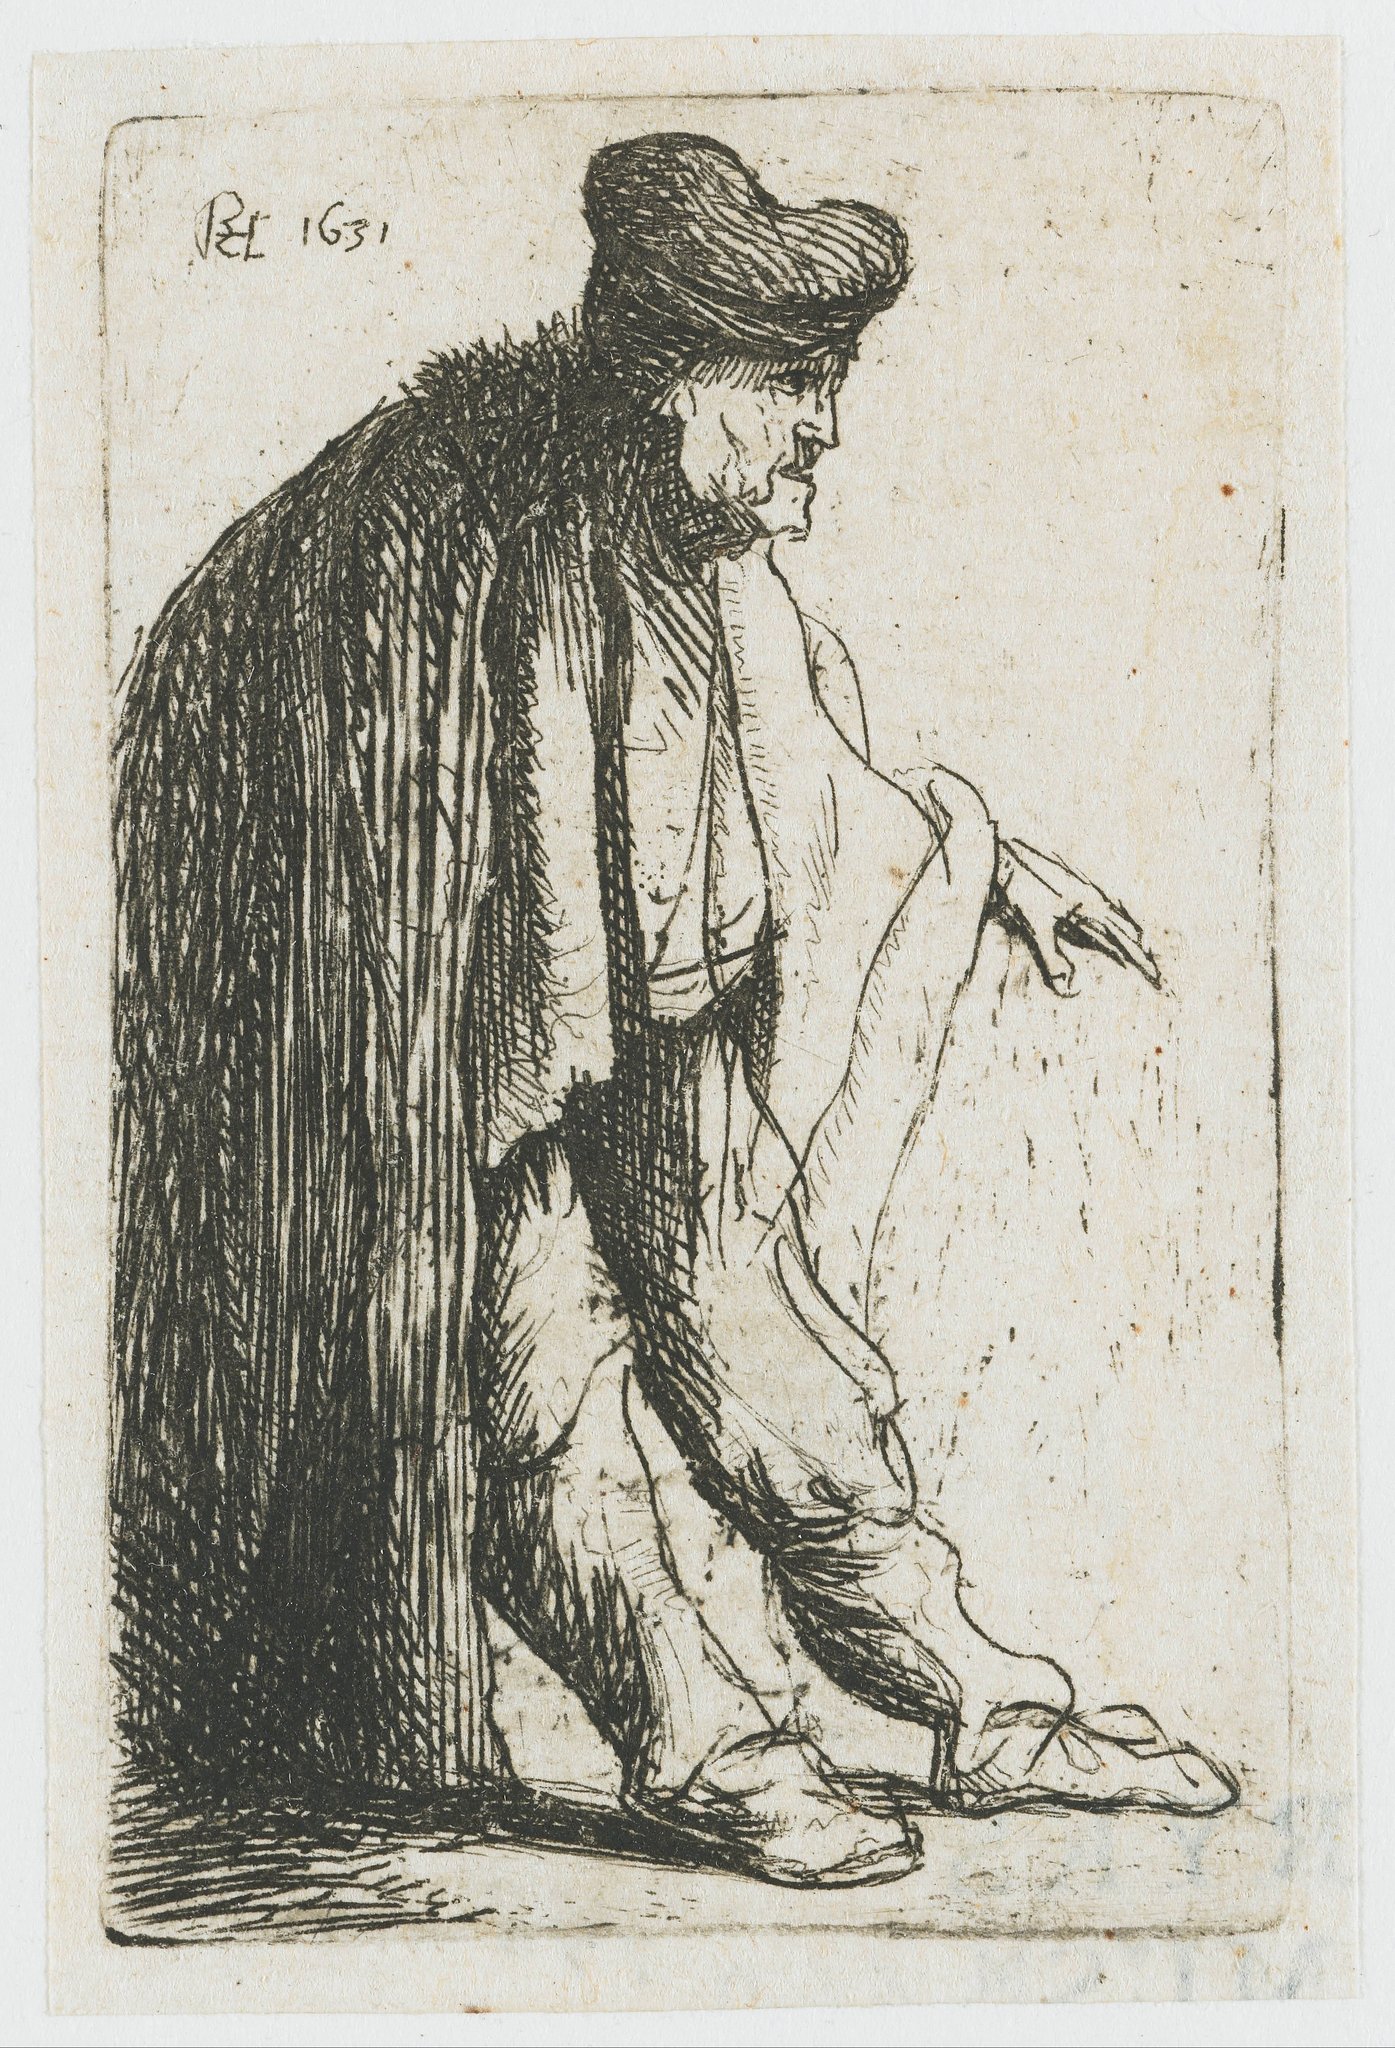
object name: print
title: Beggar with his left hand extended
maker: rembrandt van rijn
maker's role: draughtsman, painter, print maker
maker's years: 1606-1669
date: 1629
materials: paper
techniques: etching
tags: beggar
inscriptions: mark: Lugt 2165, monogram and date: ‘RHL 1631’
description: Gedateerd 1631, waarschijnlijk niet door Rembrandt.